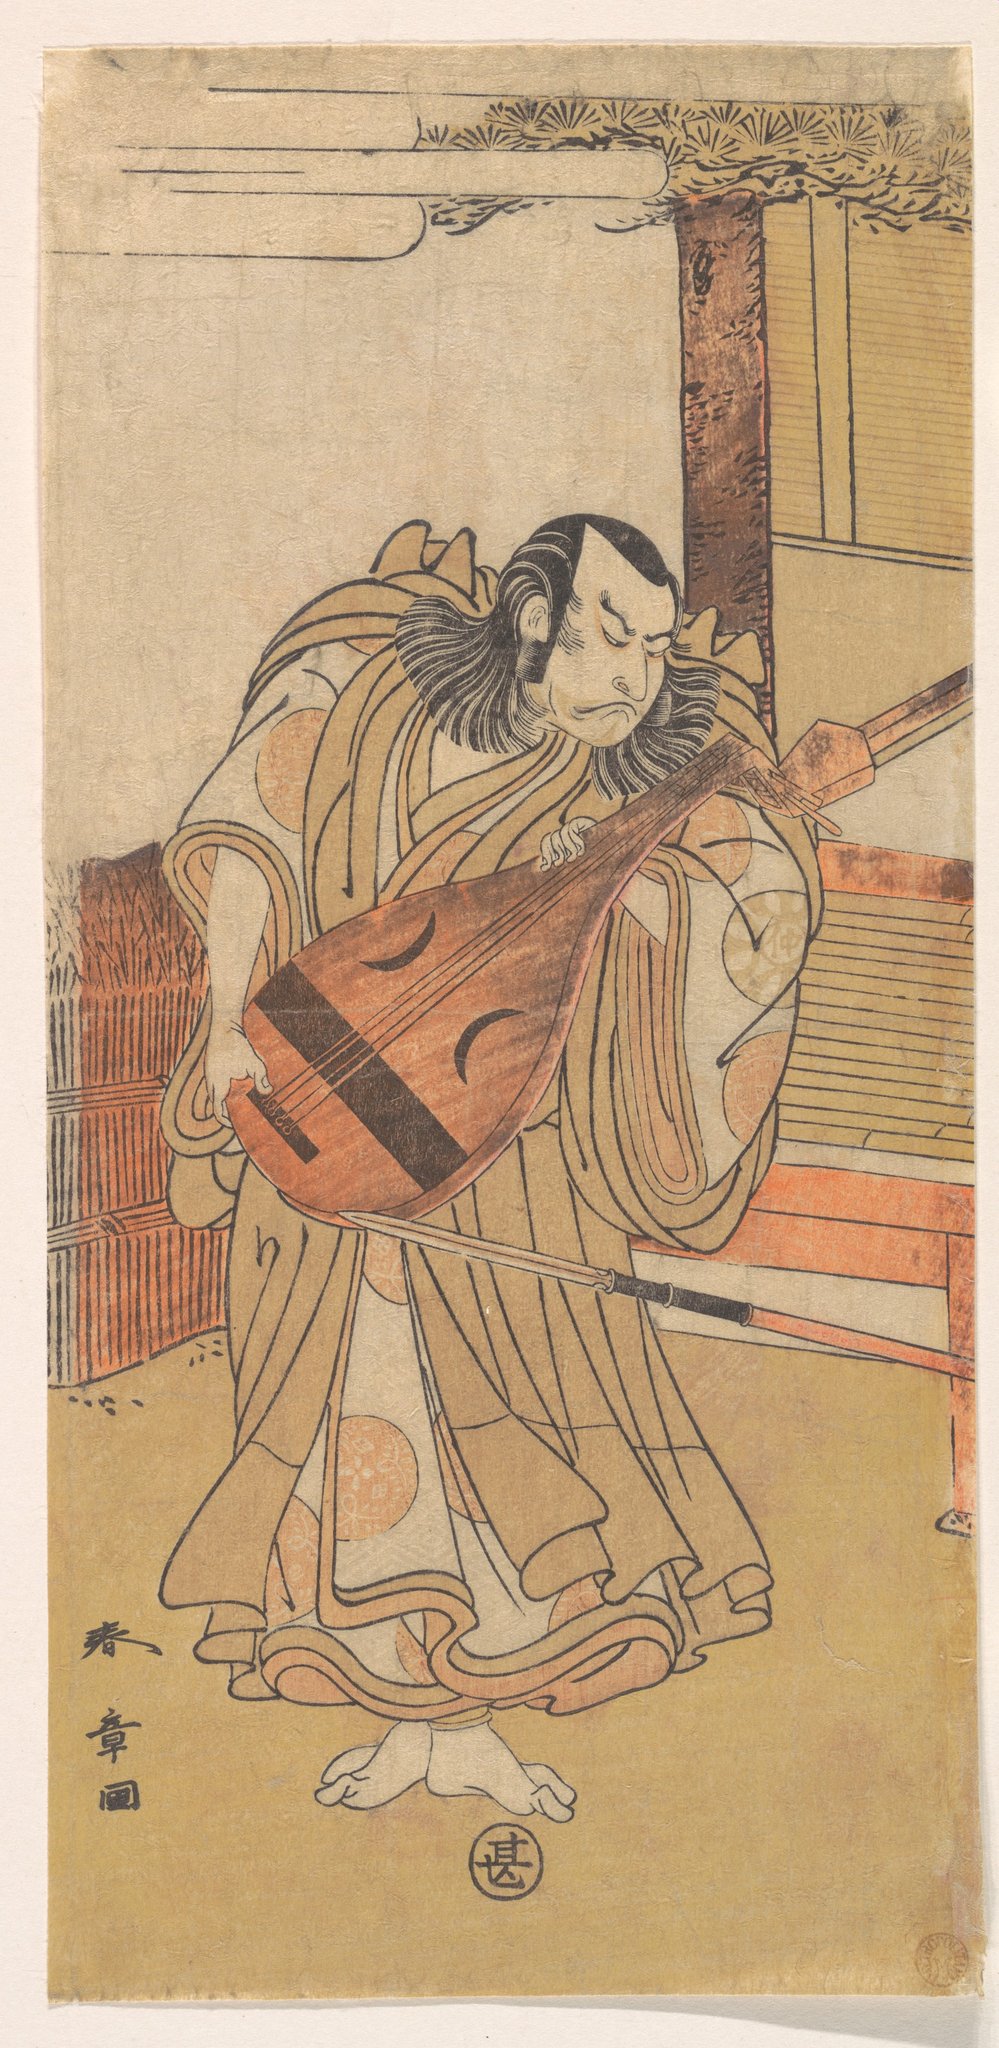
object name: woodblock print nishiki e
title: The First Nakamura Nakazo as an Unarmed Man Standing Near the Engawa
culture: japanese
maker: katsukawa shunshō 勝川春章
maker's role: artist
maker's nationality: japanese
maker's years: 1726-1792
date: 1775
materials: ink, paper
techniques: nishiki e, woodblock print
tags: human figures,musical instruments,actors